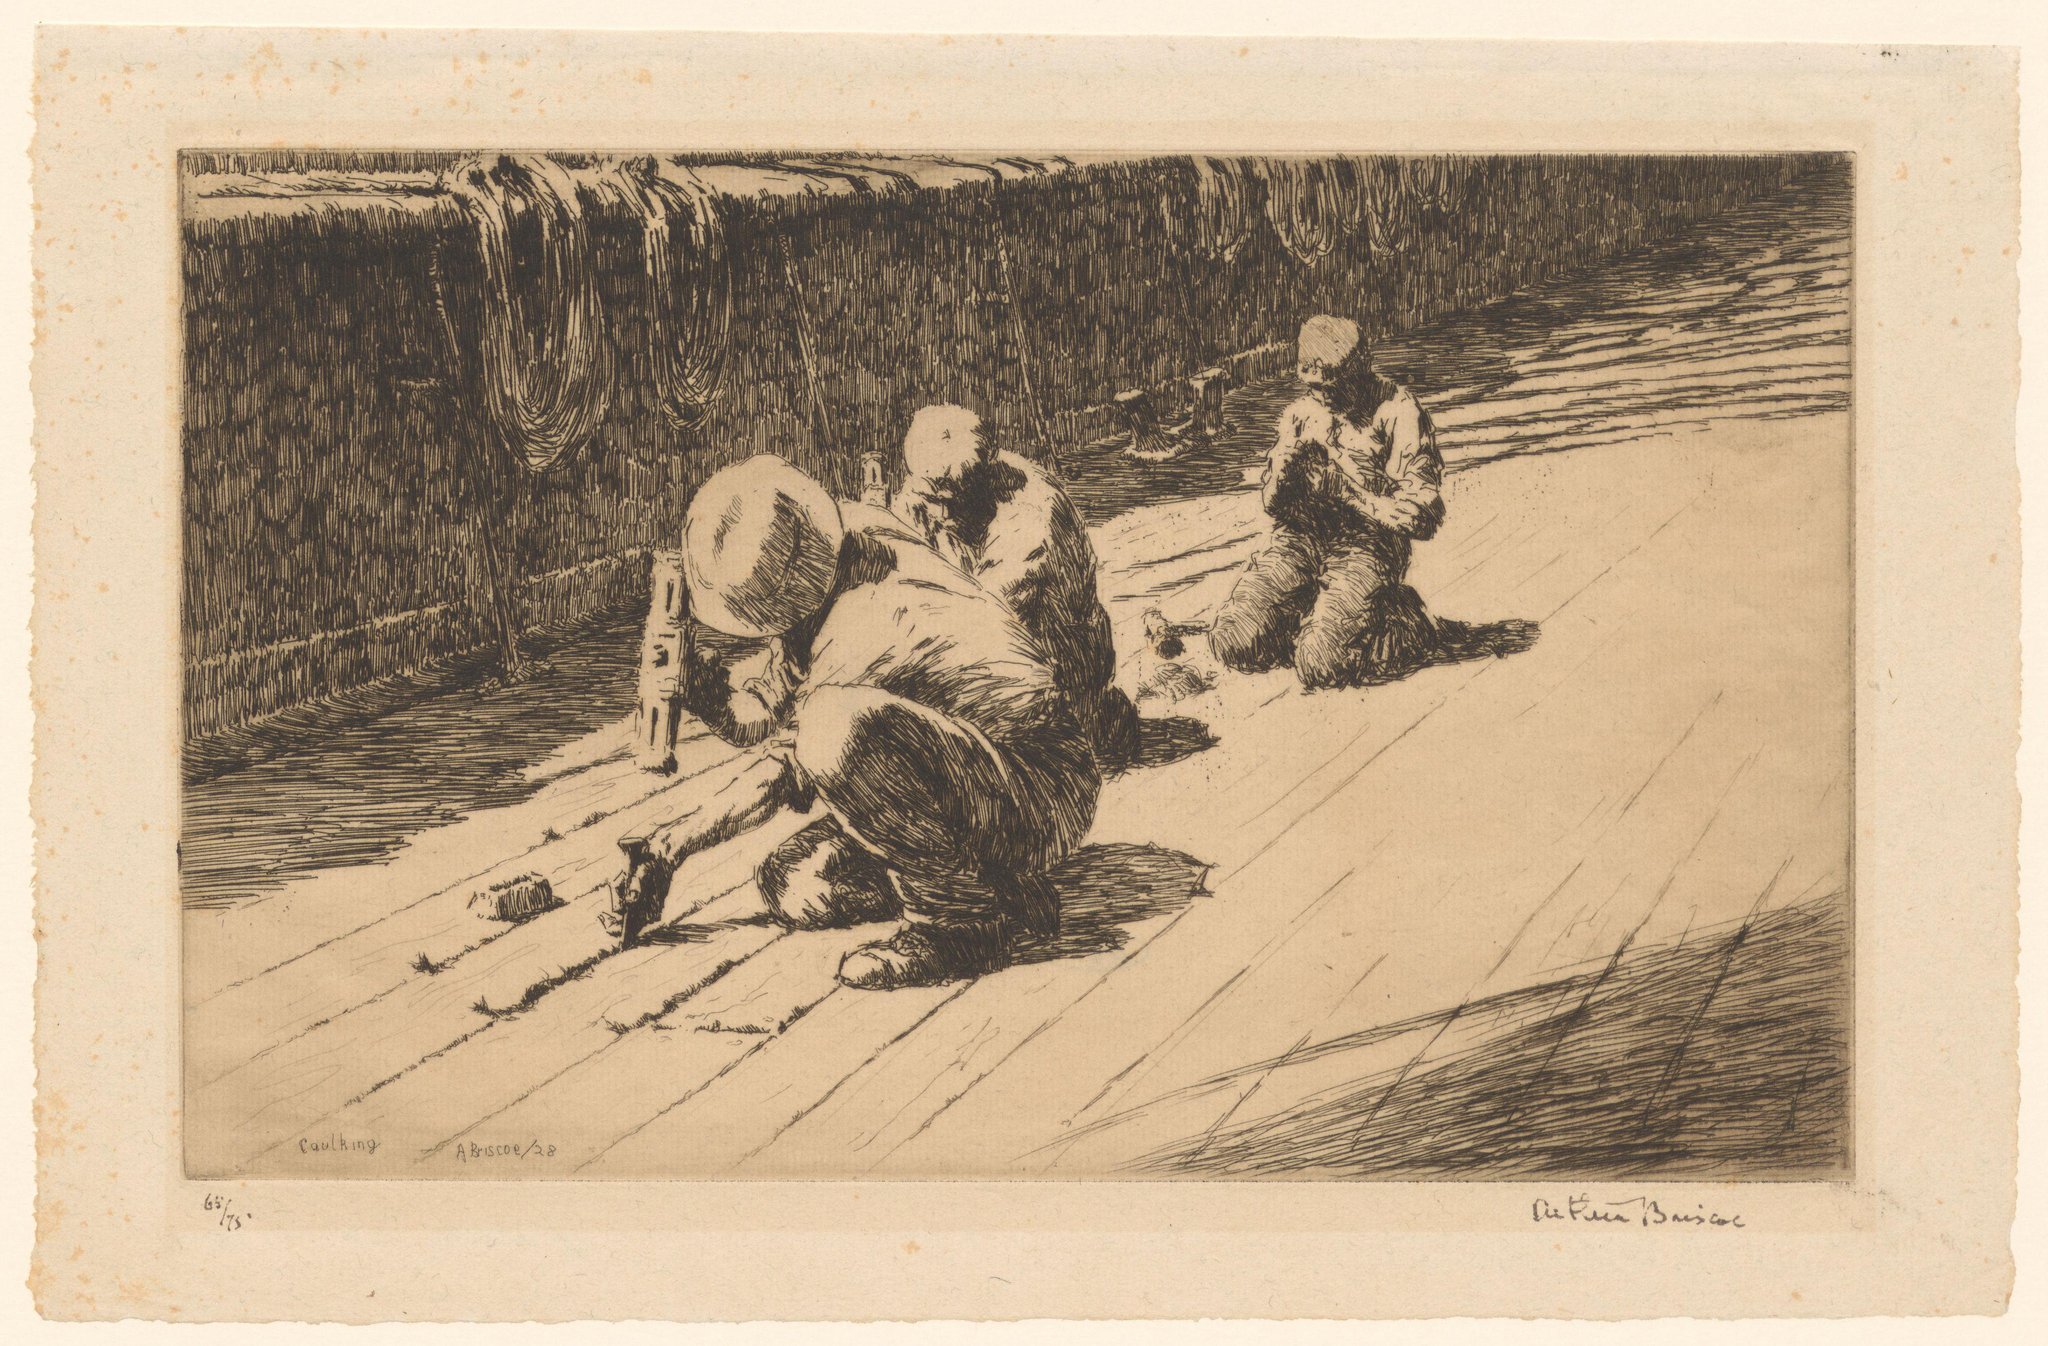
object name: print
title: Caulking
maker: arthur john trevor briscoe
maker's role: print maker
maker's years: 1873-1943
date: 1928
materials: paper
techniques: drypoint, etching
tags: repairing, caulking, careening (~ ship)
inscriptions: collector's mark: Lugt 2228